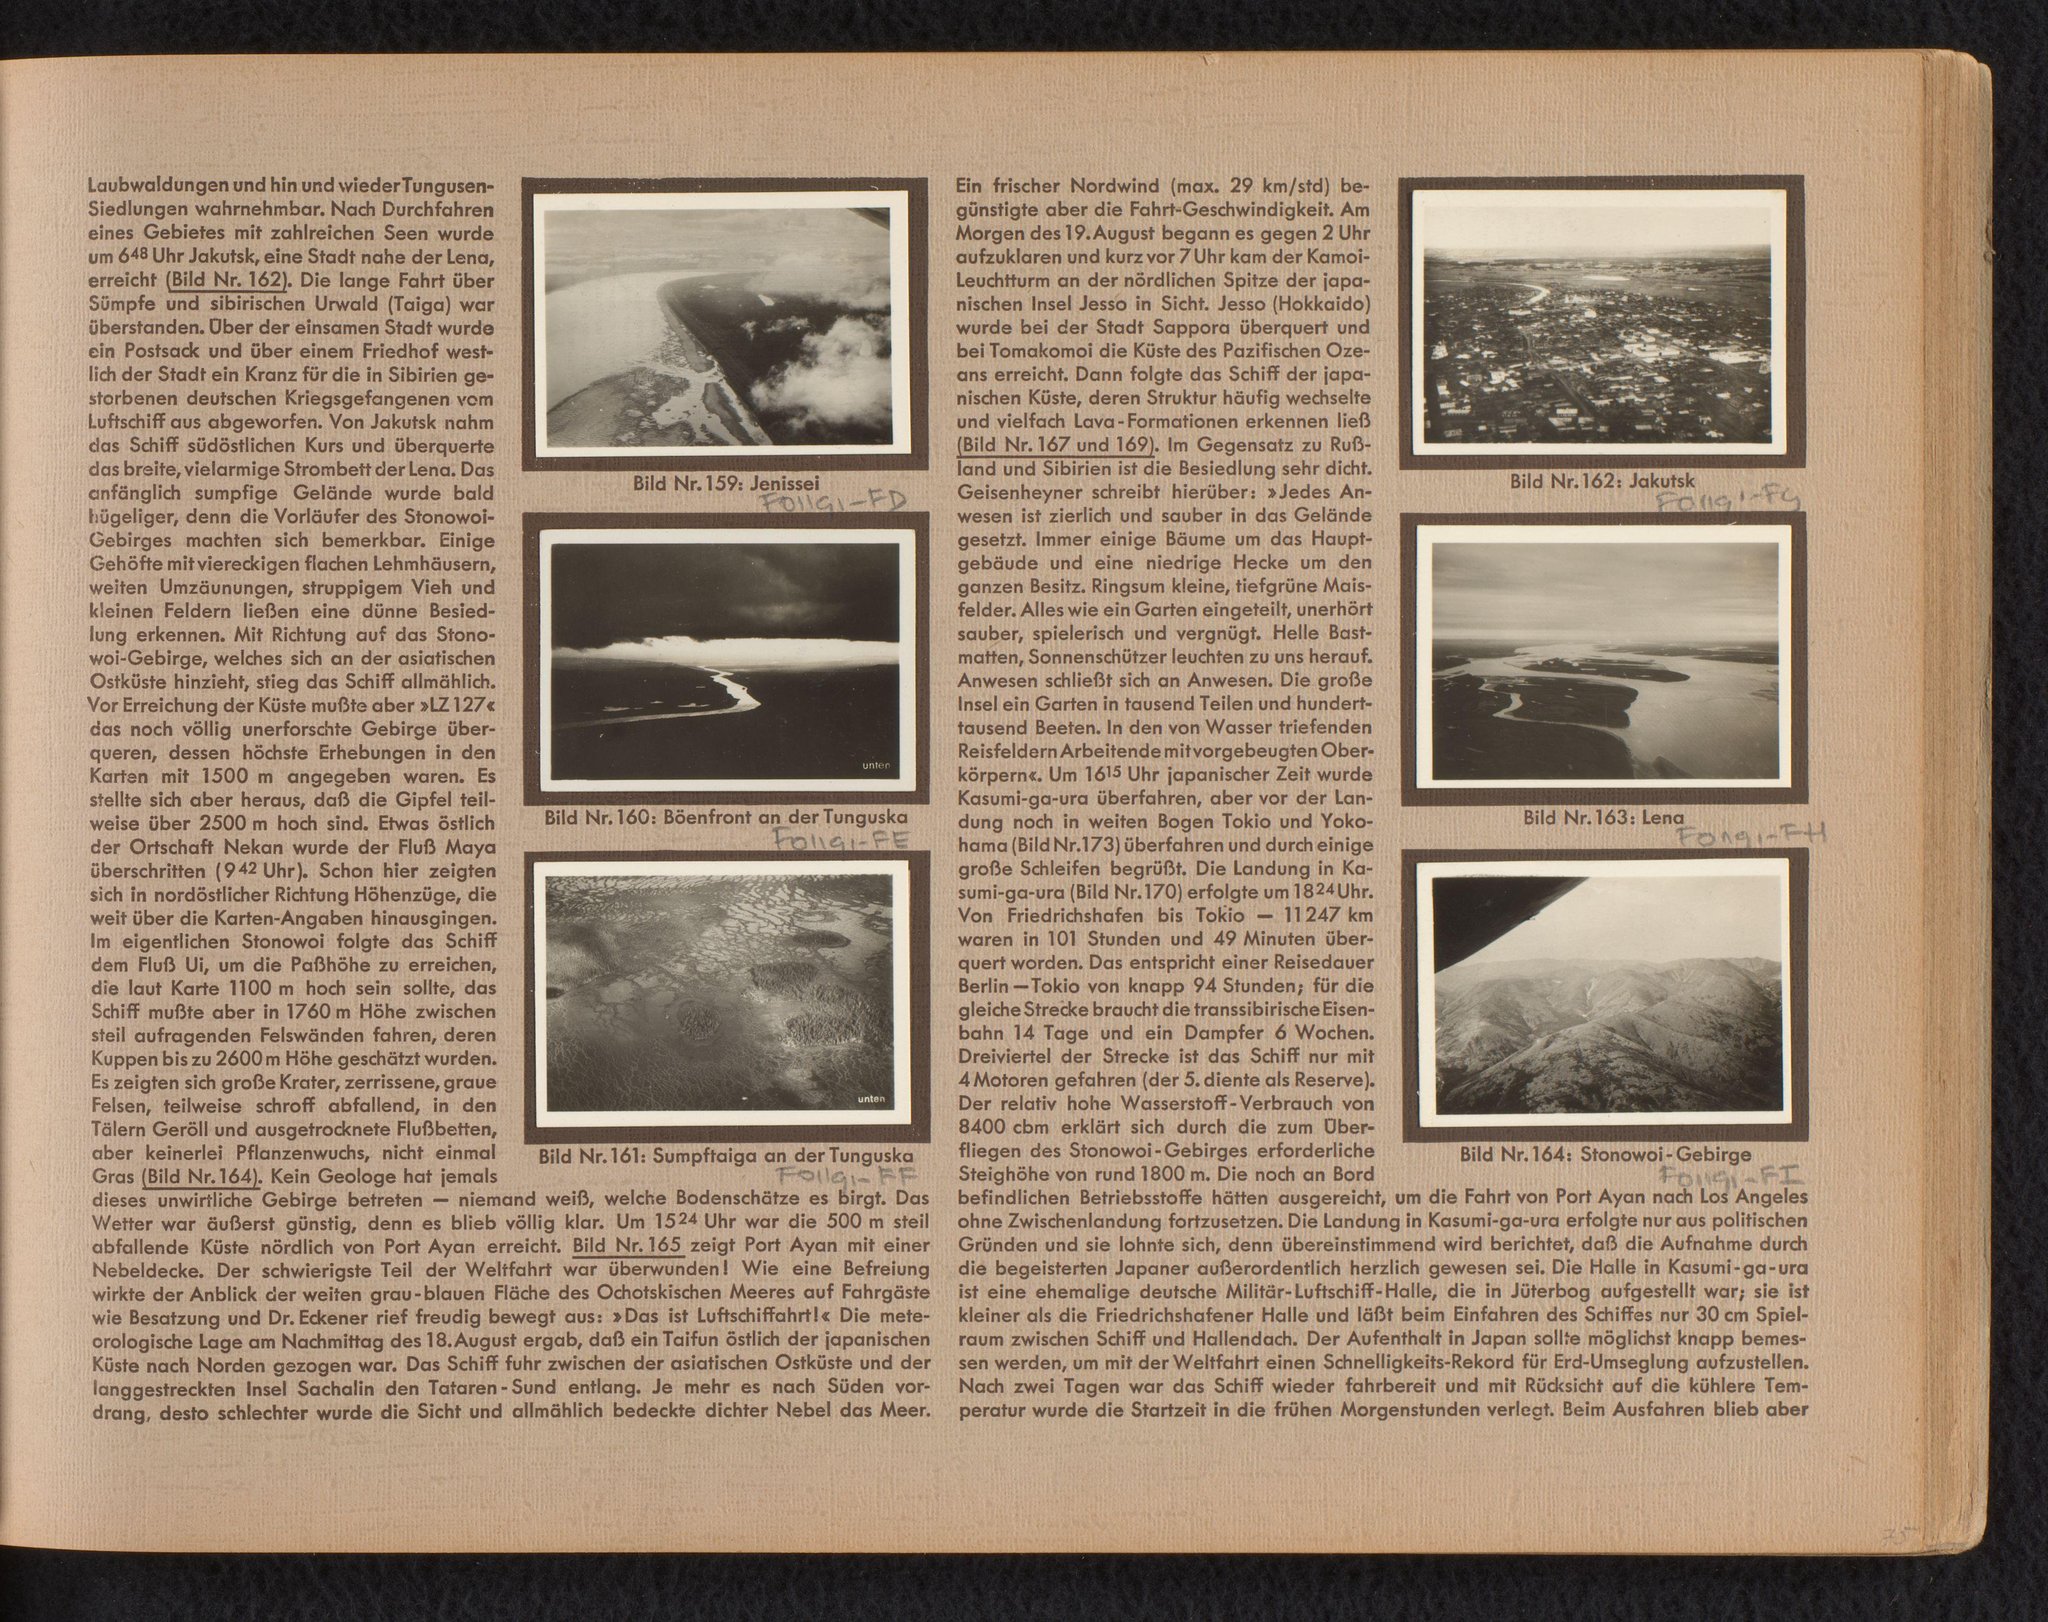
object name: photograph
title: Uitzichten tijdens een vlucht rond de aarde door de LZ127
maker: Anonymous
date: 1929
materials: paper, photographic support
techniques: gelatin silver print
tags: city-view, and landscape with man-made constructions, river, mountains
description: Zes foto's gemaakt tijdens een vlucht rond de aarde, waaronder gezichten op de Jennisej, Jaboetsk. Alle foto's zijn voorzien van een nummer en titel. Deze pagina maakt deel uit van een album.